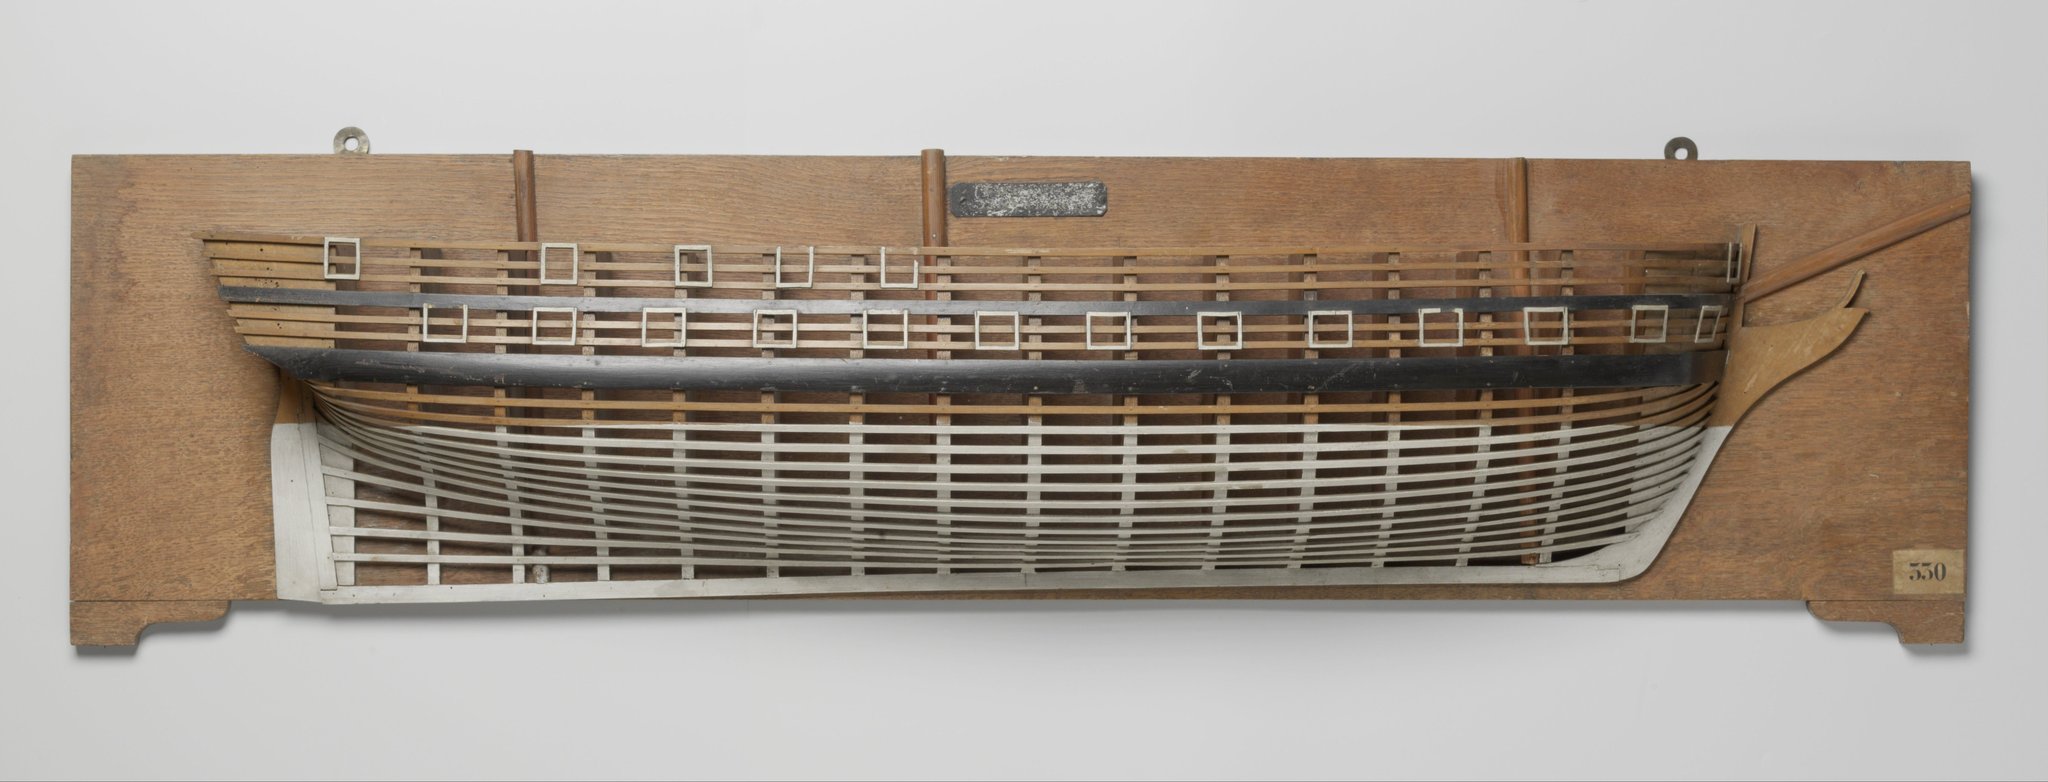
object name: half model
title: Half Model of a 32-Gun Sloop of War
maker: Anonymous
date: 1830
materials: wood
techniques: polychromy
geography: netherlands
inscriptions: inscription, top centre, on a rectangular black label: ‘Corvet / 32 Stukken’, label, bottom right: ‘330’ former inventory label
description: Gepolychromeerd mallenmodel (stuurboord) van een driemaster. Twintig geschutpoorten aangegeven op twee dekken. Gewrongen spiegel, hol wulf, geen details van het hek, geen zijgalerij; roer met ronde roerkoning (Soetermeers versie), roerblad afgerond bij de waterlijn. Zeeg voor en achter iets oplopend, één barkhout en één reehout. Gepiekt rondspant.